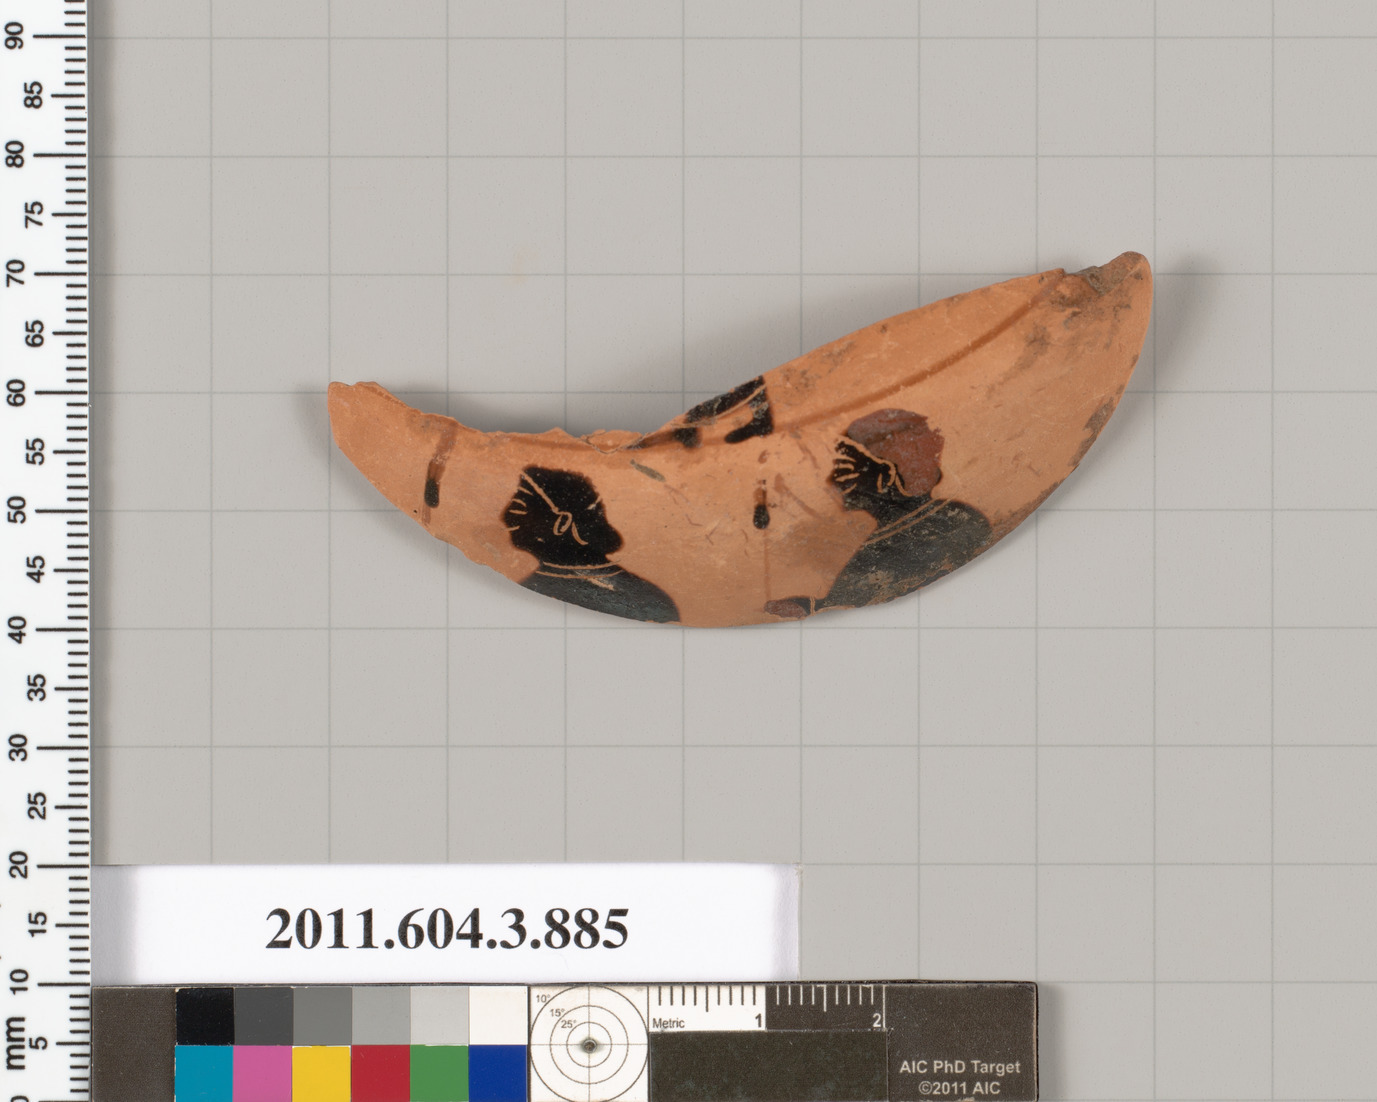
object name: lekythos fragment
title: Terracotta fragment of a lekythos (oil flask)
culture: greek, attic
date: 534-501 BCE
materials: terracotta